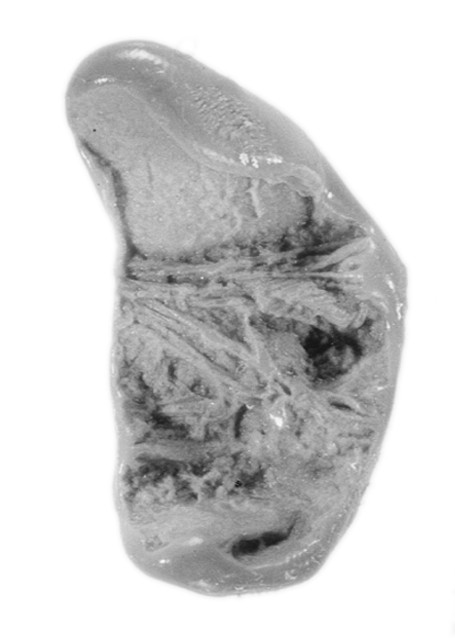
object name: sealing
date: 1981-1640 BCE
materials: mud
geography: egypt